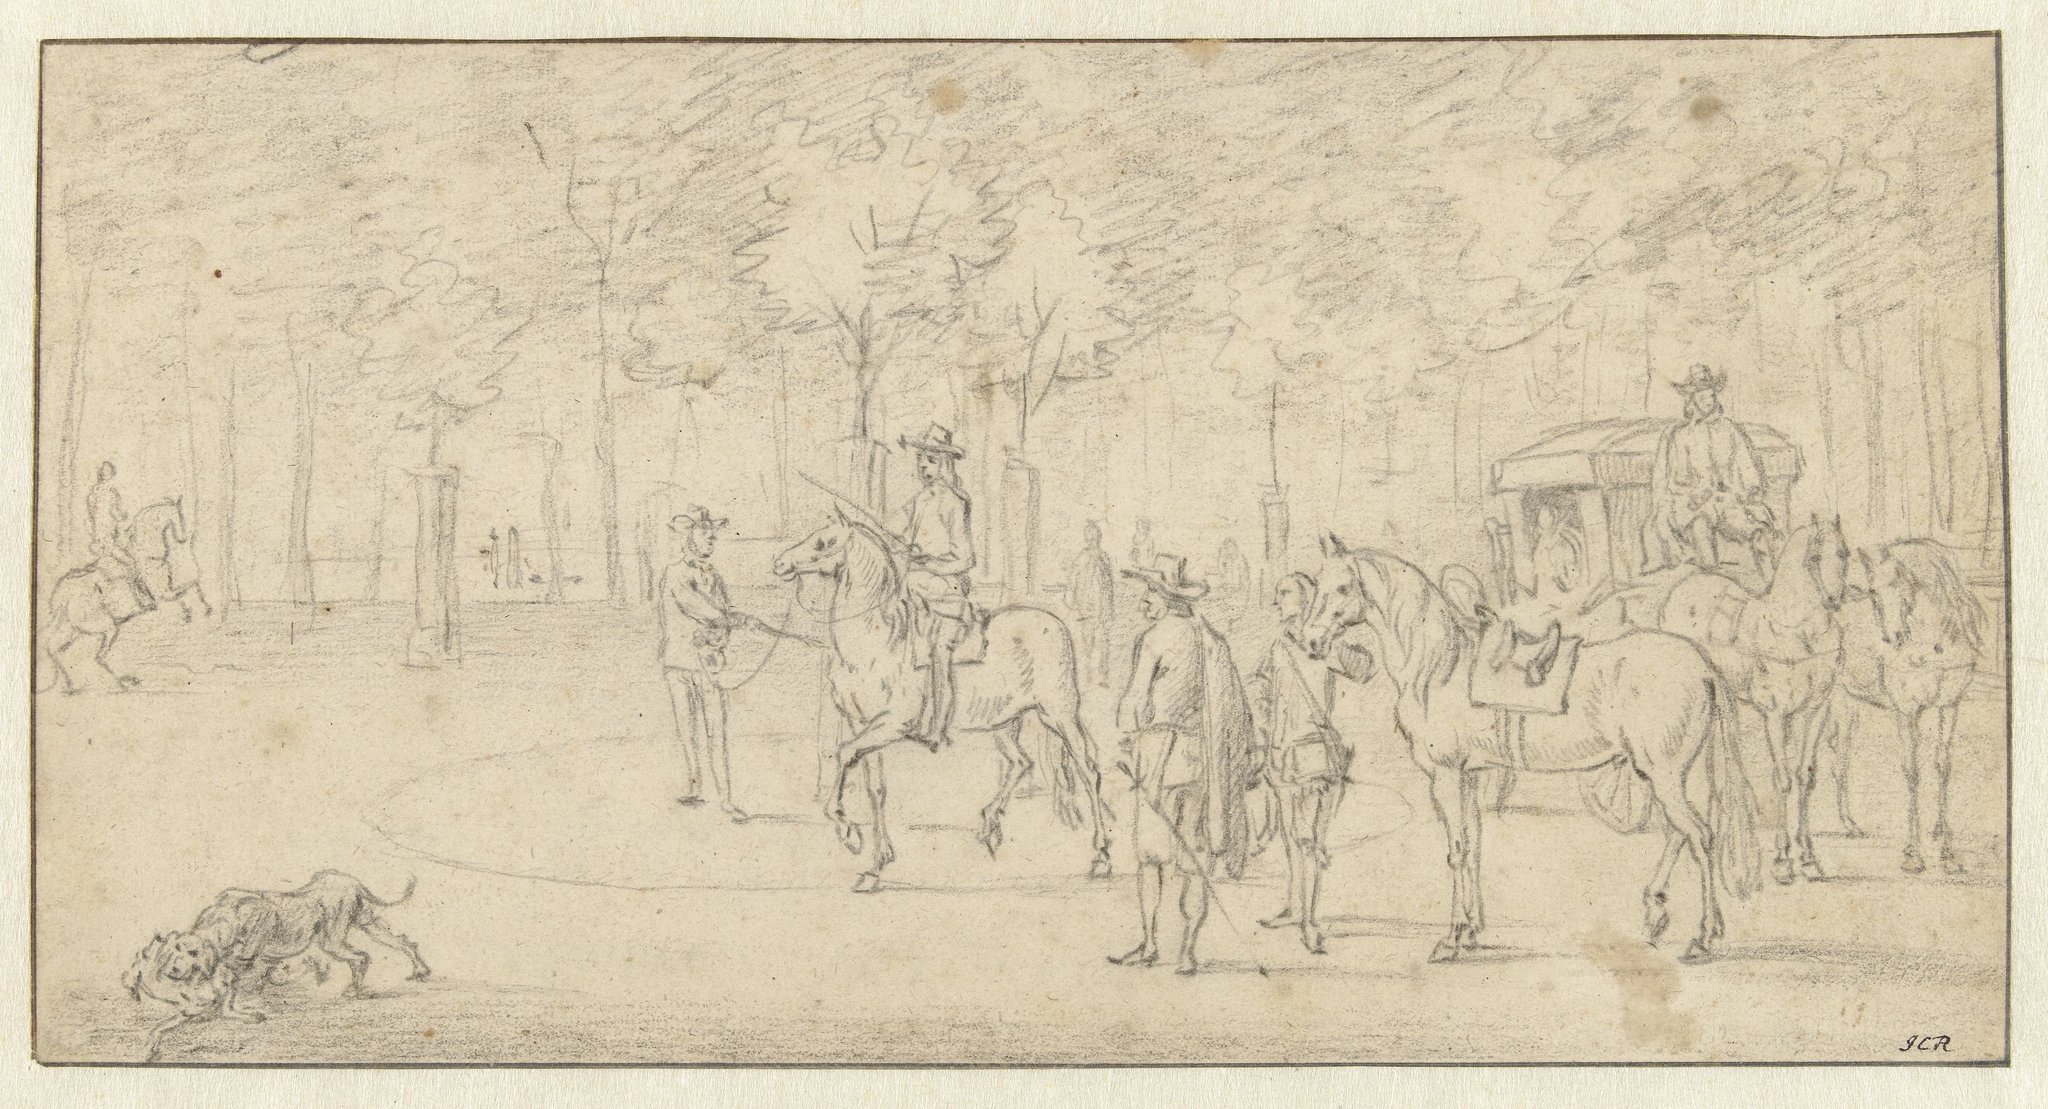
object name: drawing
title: Riding Lesson in a Park, with a Carriage and Other Figures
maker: dirk maas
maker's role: draughtsman, print maker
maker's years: 1659-1717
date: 1690-1696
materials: paper, pencil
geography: haarlem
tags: training of horses, riding-school, manège